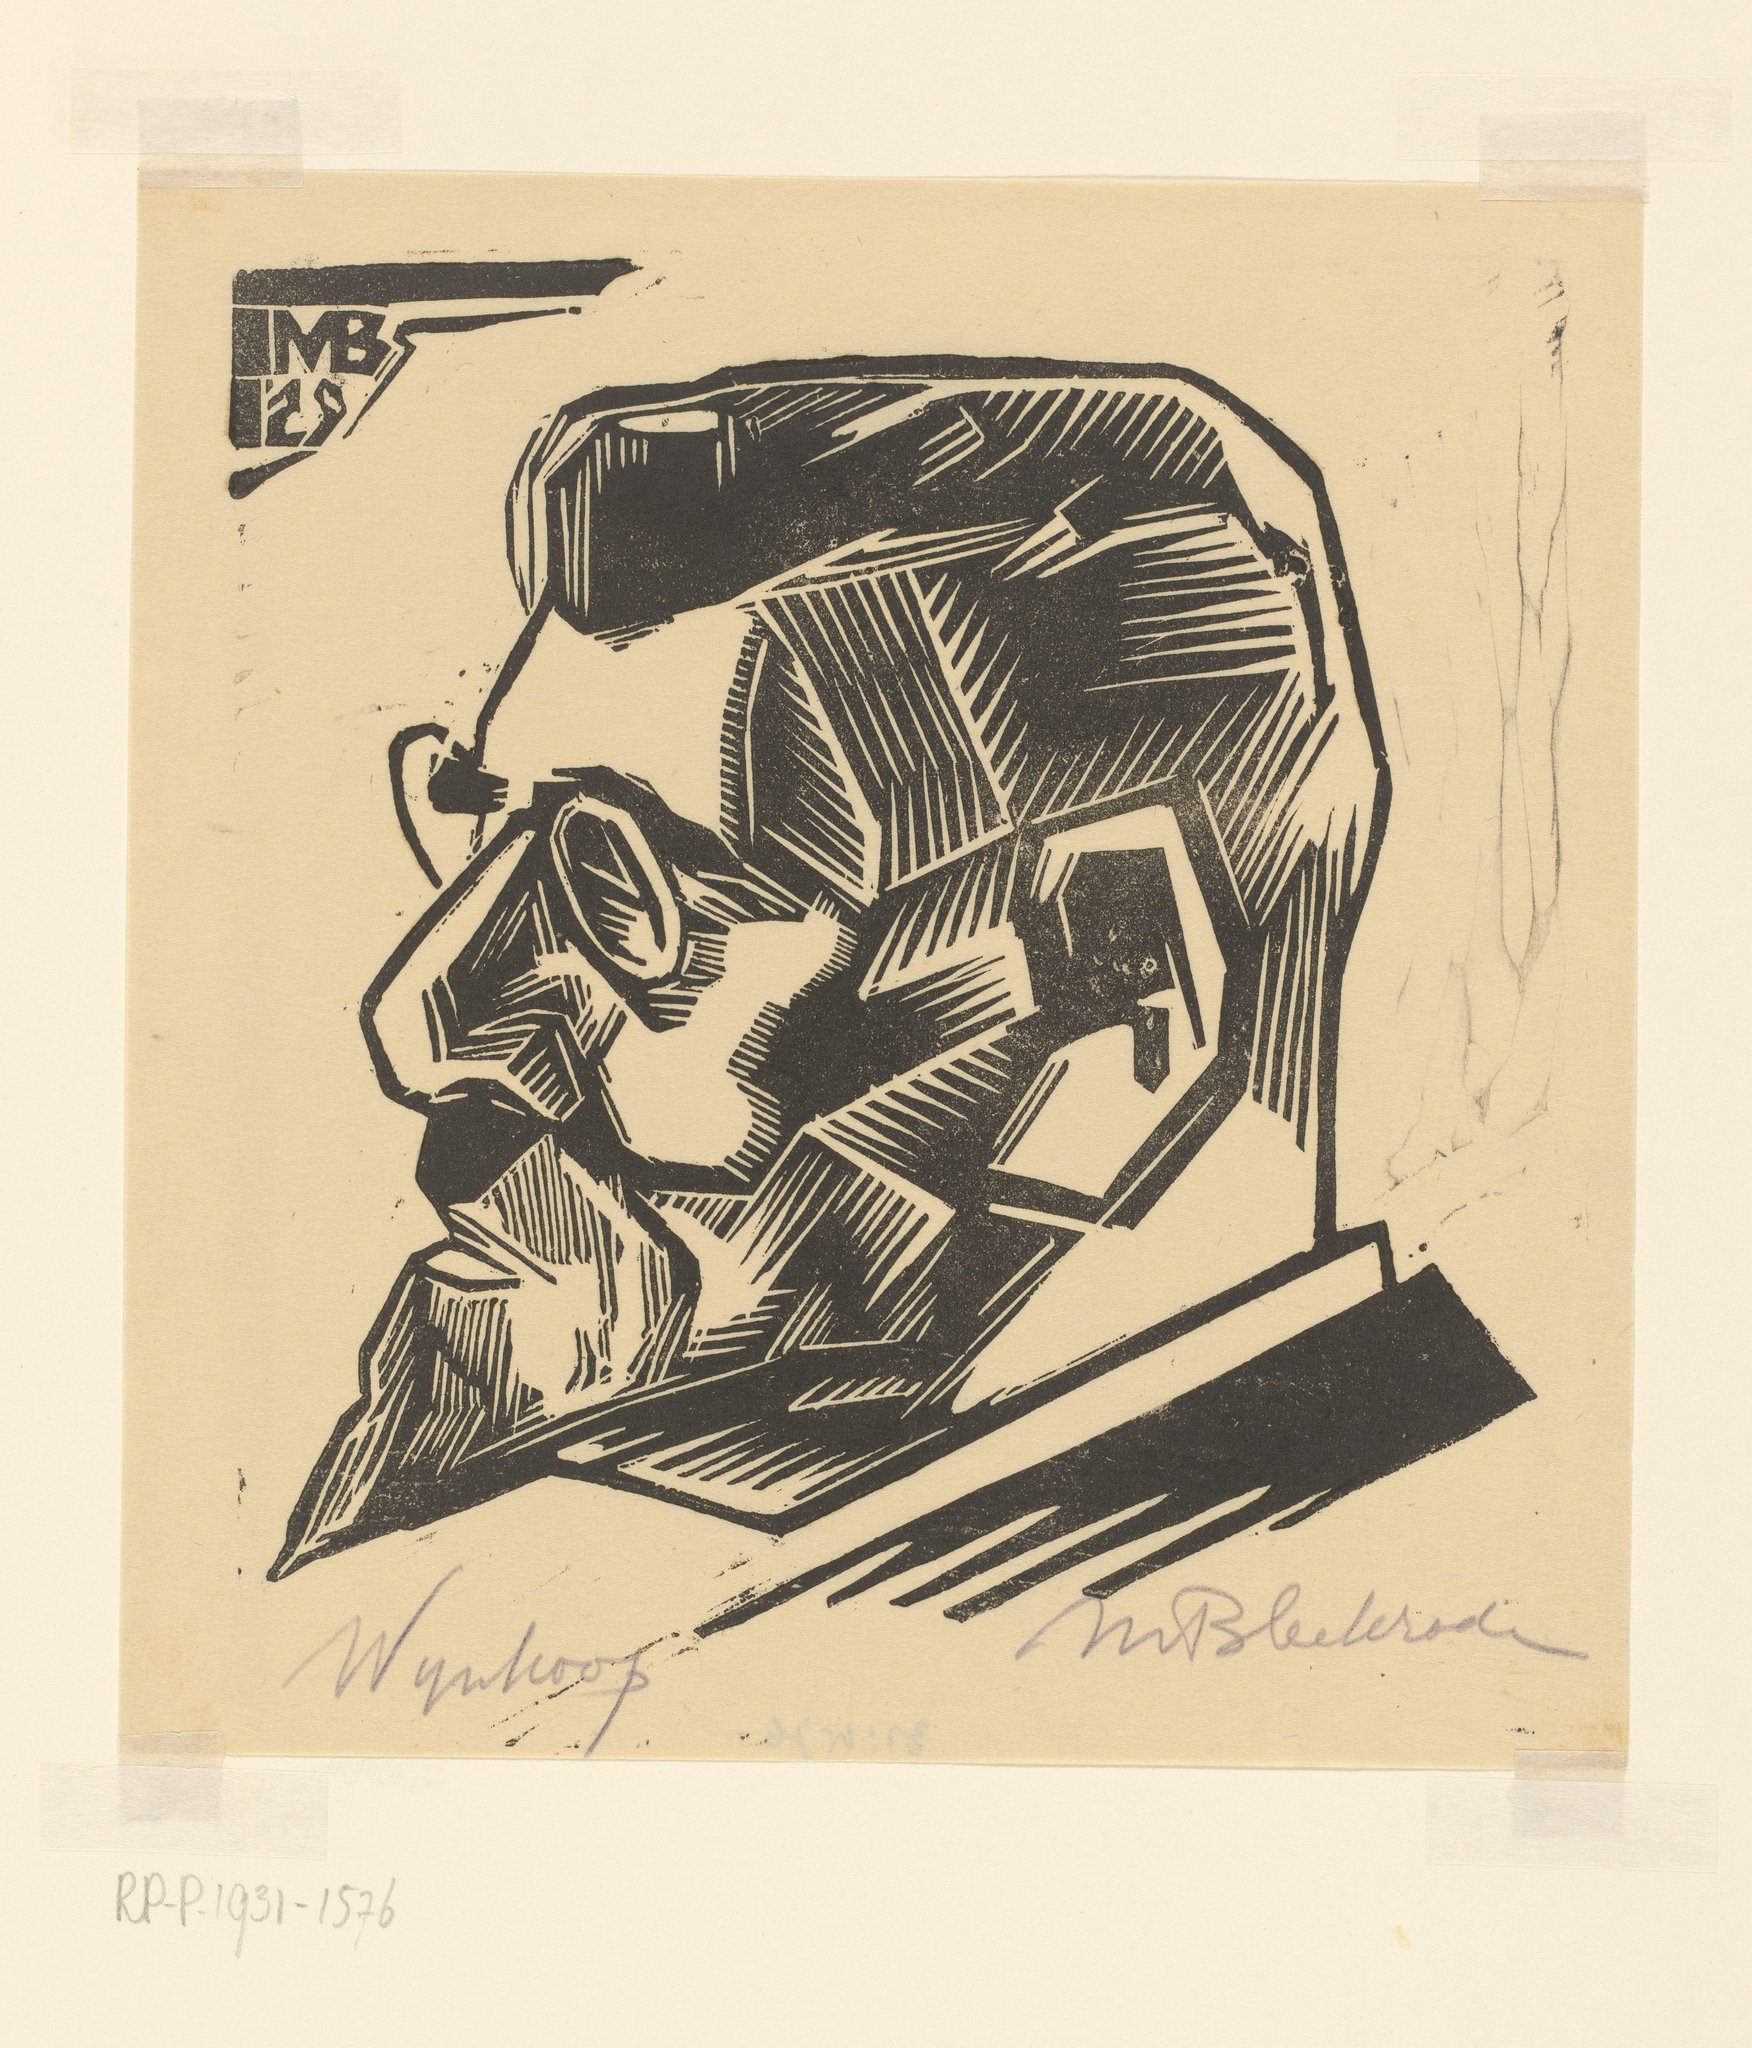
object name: print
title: Portret van David Wijnkoop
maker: meijer bleekrode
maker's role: draughtsman, painter, print maker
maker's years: 1896-1943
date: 1929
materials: paper, ink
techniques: woodcut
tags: politician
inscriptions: monogram and date: ‘MB '29’, title: ‘Wijnkoop’, signature: ‘MBleekrode’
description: Kop van een man met een puntbaard en een bril, en profil, gestileerd weergegeven.